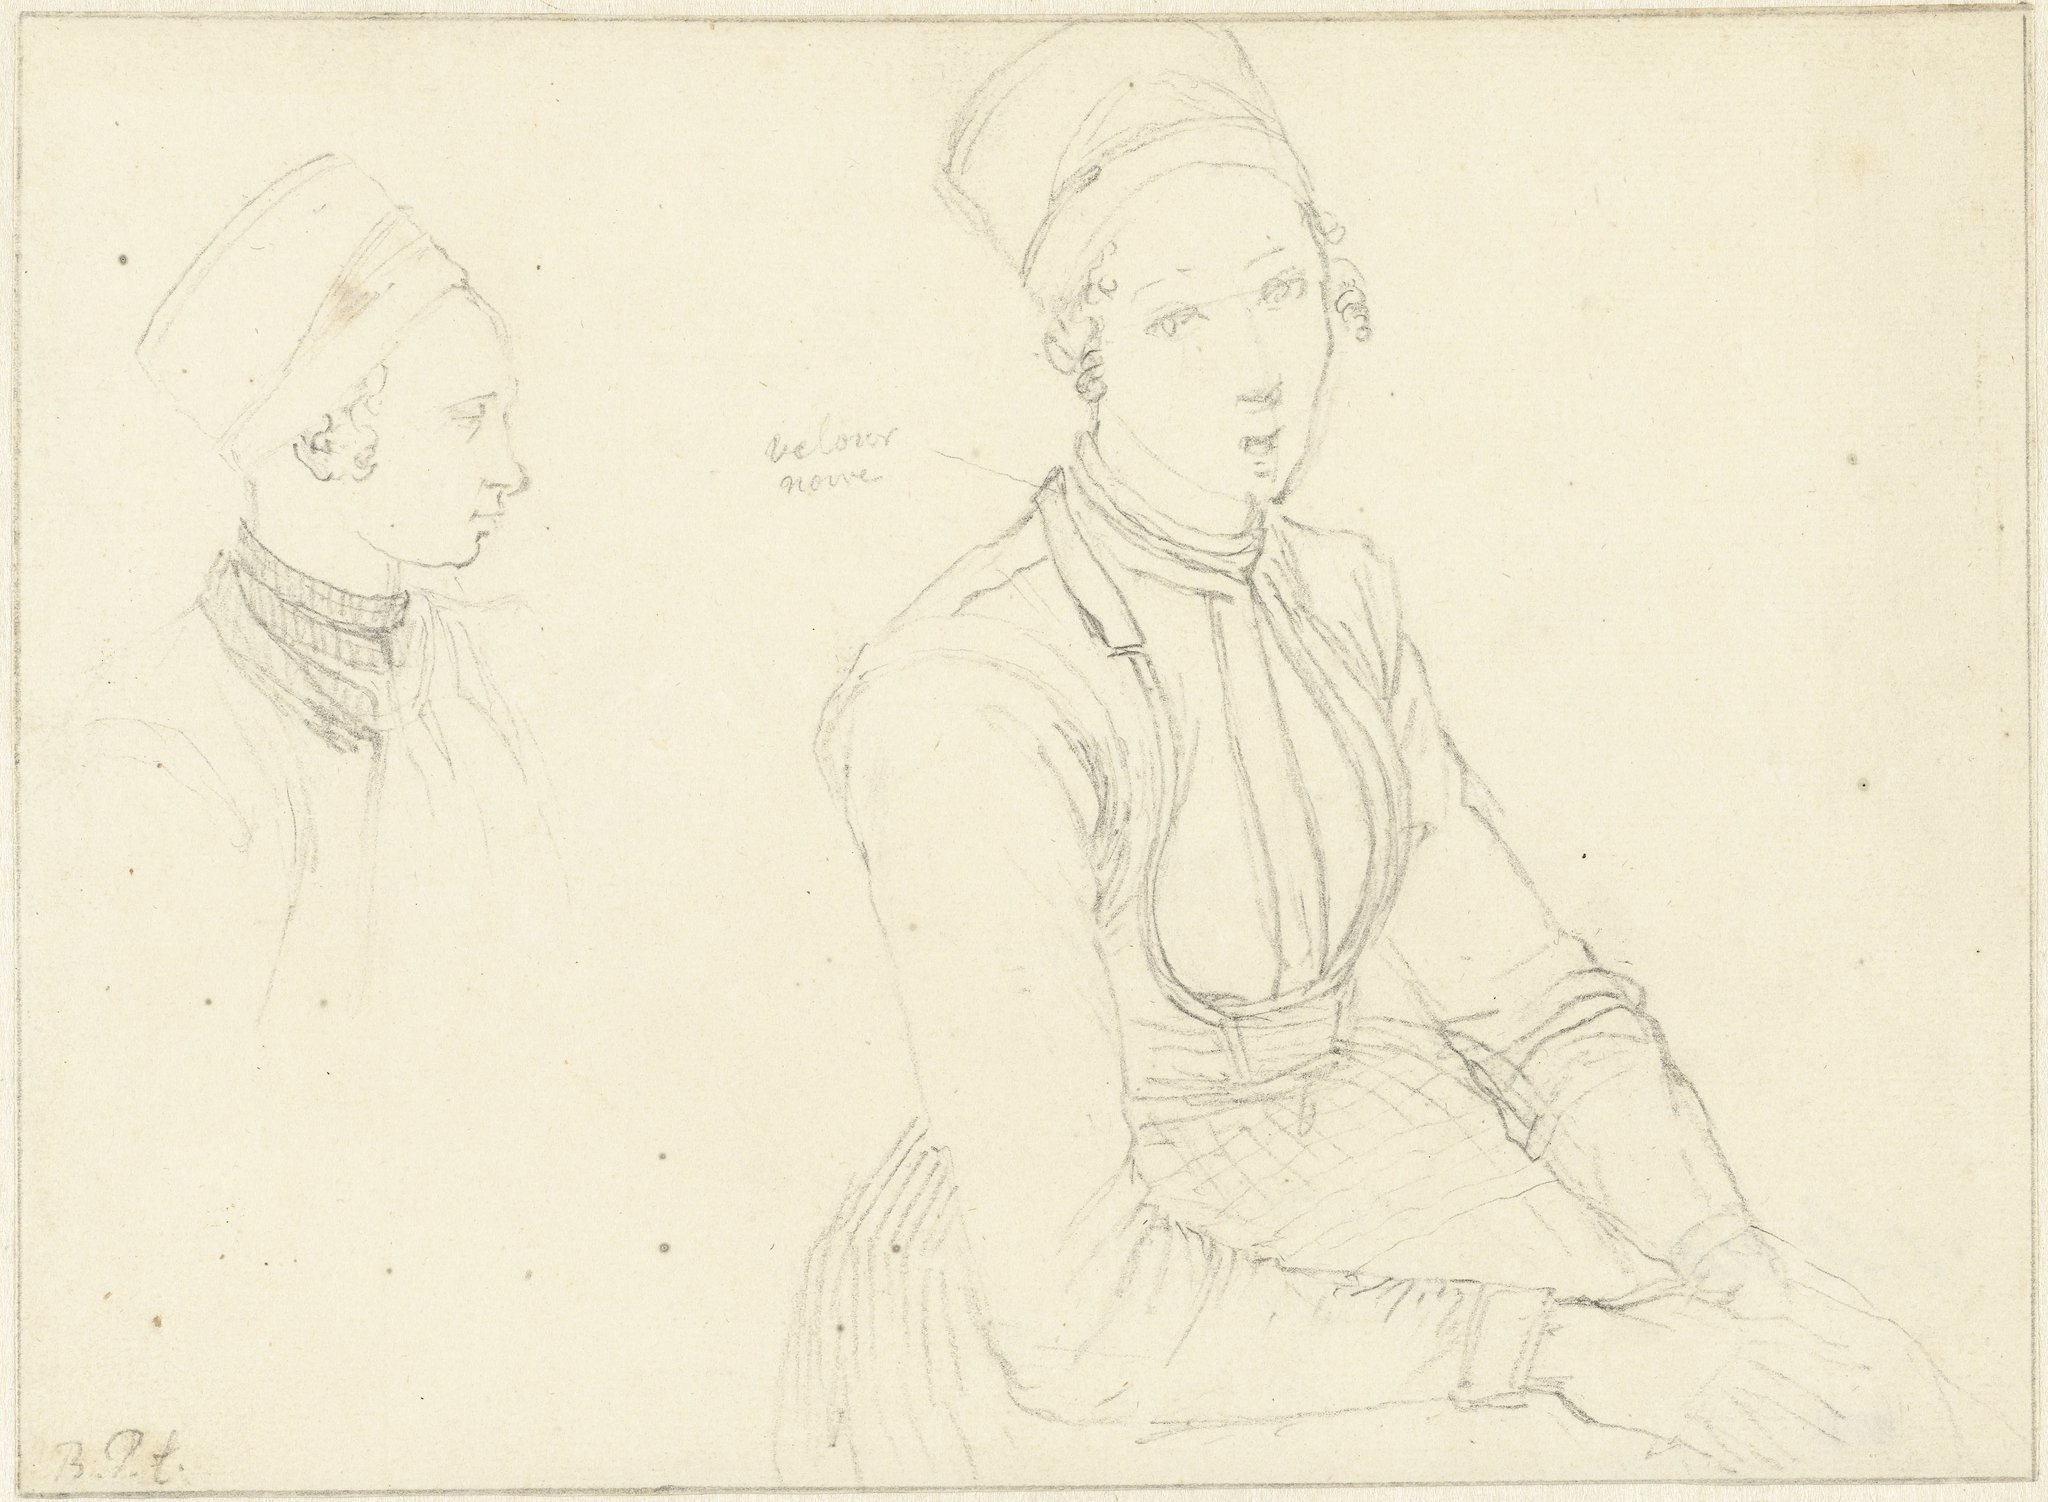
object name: drawing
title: Twee schetsen naar het kostuum van een Marker vrouw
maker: bernard picart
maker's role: draughtsman, print maker, publisher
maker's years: 1673-1733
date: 1683-1733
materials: paper, pencil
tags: folk costume, regional costume